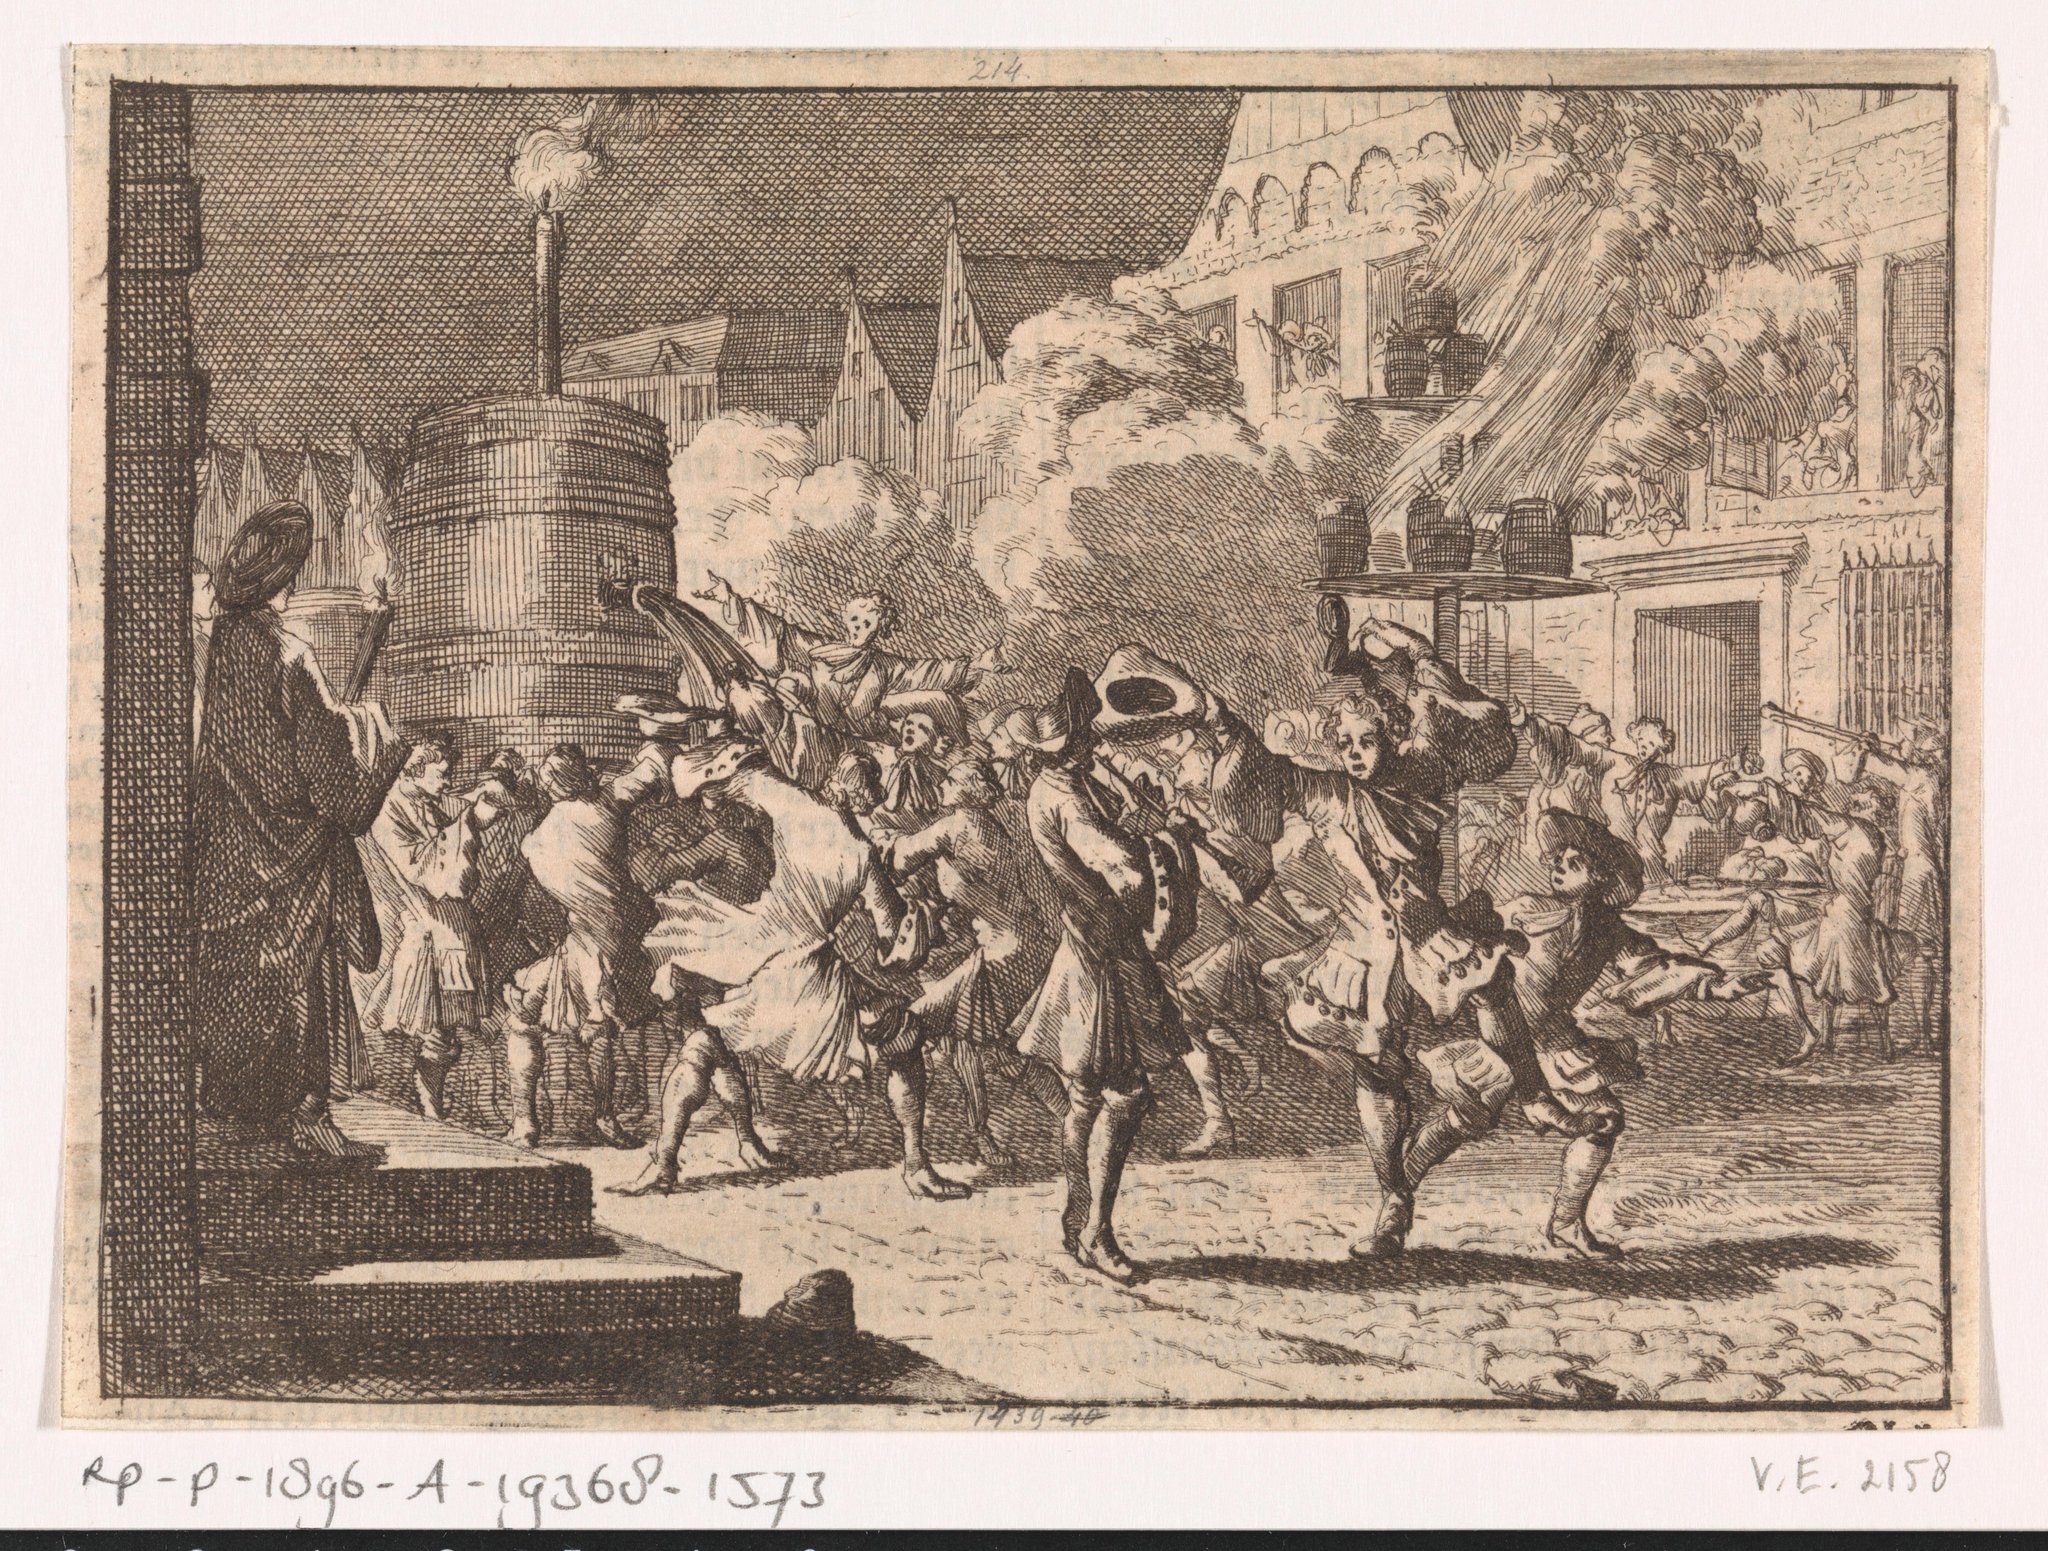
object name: print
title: Vreugde in Parijs naar aanleiding van het valse bericht van de dood van Willem III bij de slag aan de Boyne, 1690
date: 1698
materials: paper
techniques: etching, letterpress printing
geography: leiden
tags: the hague, william iii (prince of orange and king of england, scotland, and ireland), public festivities, paris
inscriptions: collector's mark: Lugt 2228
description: Illustratie uit: Gottfried, Johann Ludwig. Historische kronyck; vervattende een (...) beschrijvingh der aldergedenckwaerdigste geschiedenissen des weerelds, van den aenvangh der scheppingh tot (...) 1576 (2 delen). Leiden: Pieter van der Aa, 1698, dl. II, p. 1439.